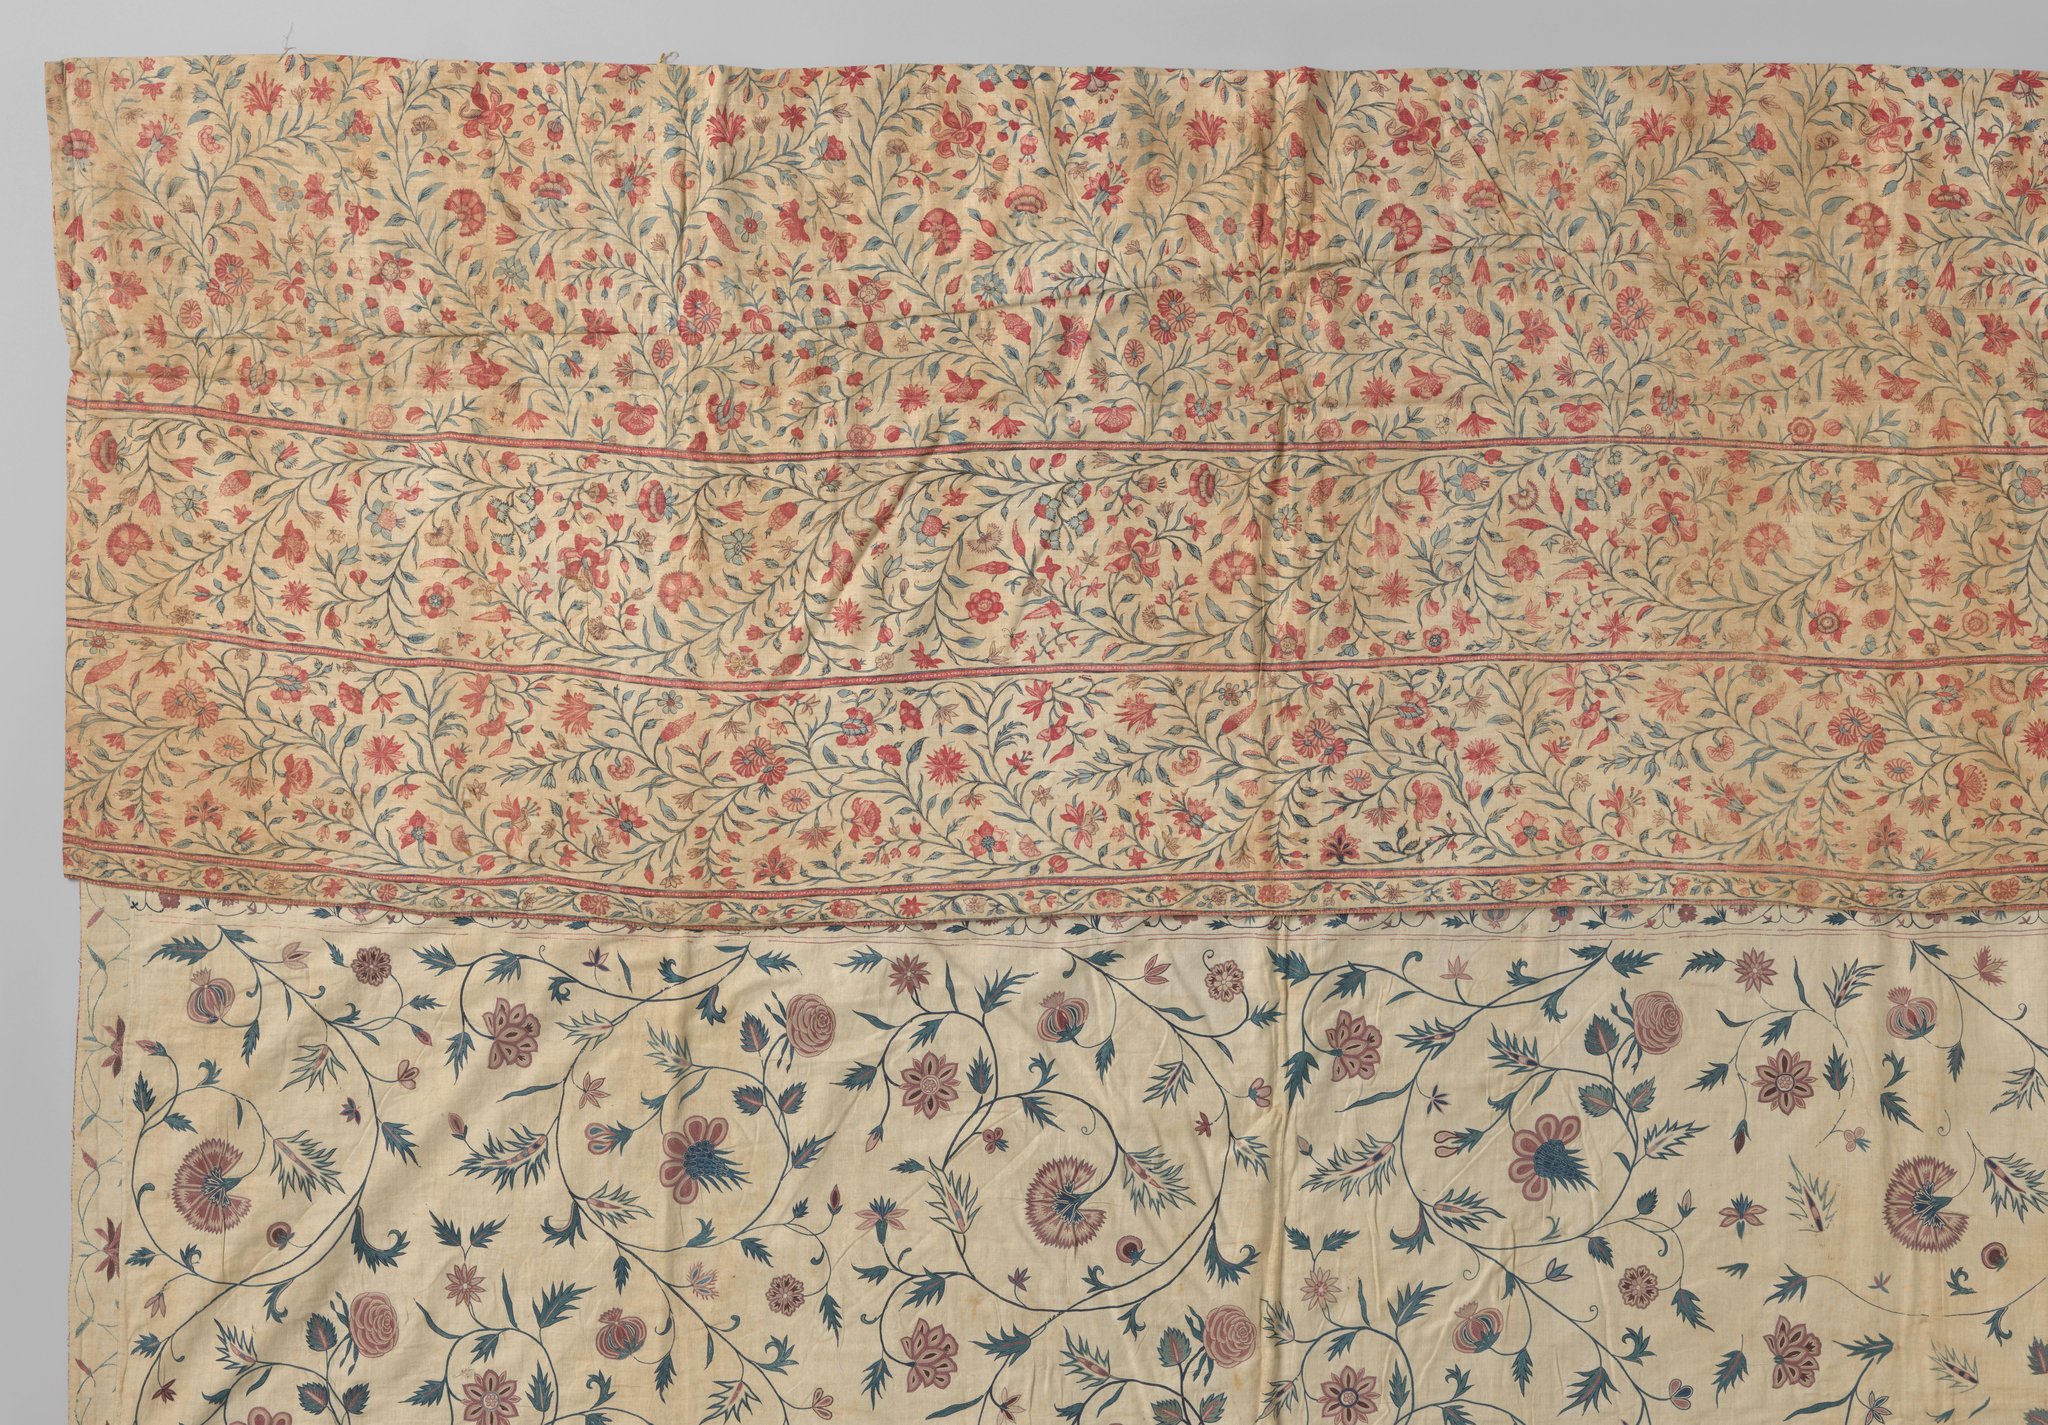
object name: bed covering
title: Sprei van wit keper met tamboereerwerk, waaraan een lap sits is genaaid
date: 1750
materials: cotton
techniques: embroidered, printing, weave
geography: iran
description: Sprei bestaande uit vier aaneengenaaide fragmenten. Het middenstuk met boven- en onderrand zijn bewerkt met dunne ranken met diverse bloemen, waaronder anjers in tamboereerwerk. Aan de bovenrand is een lap versleten sits genaaid. Oosterse textiel.